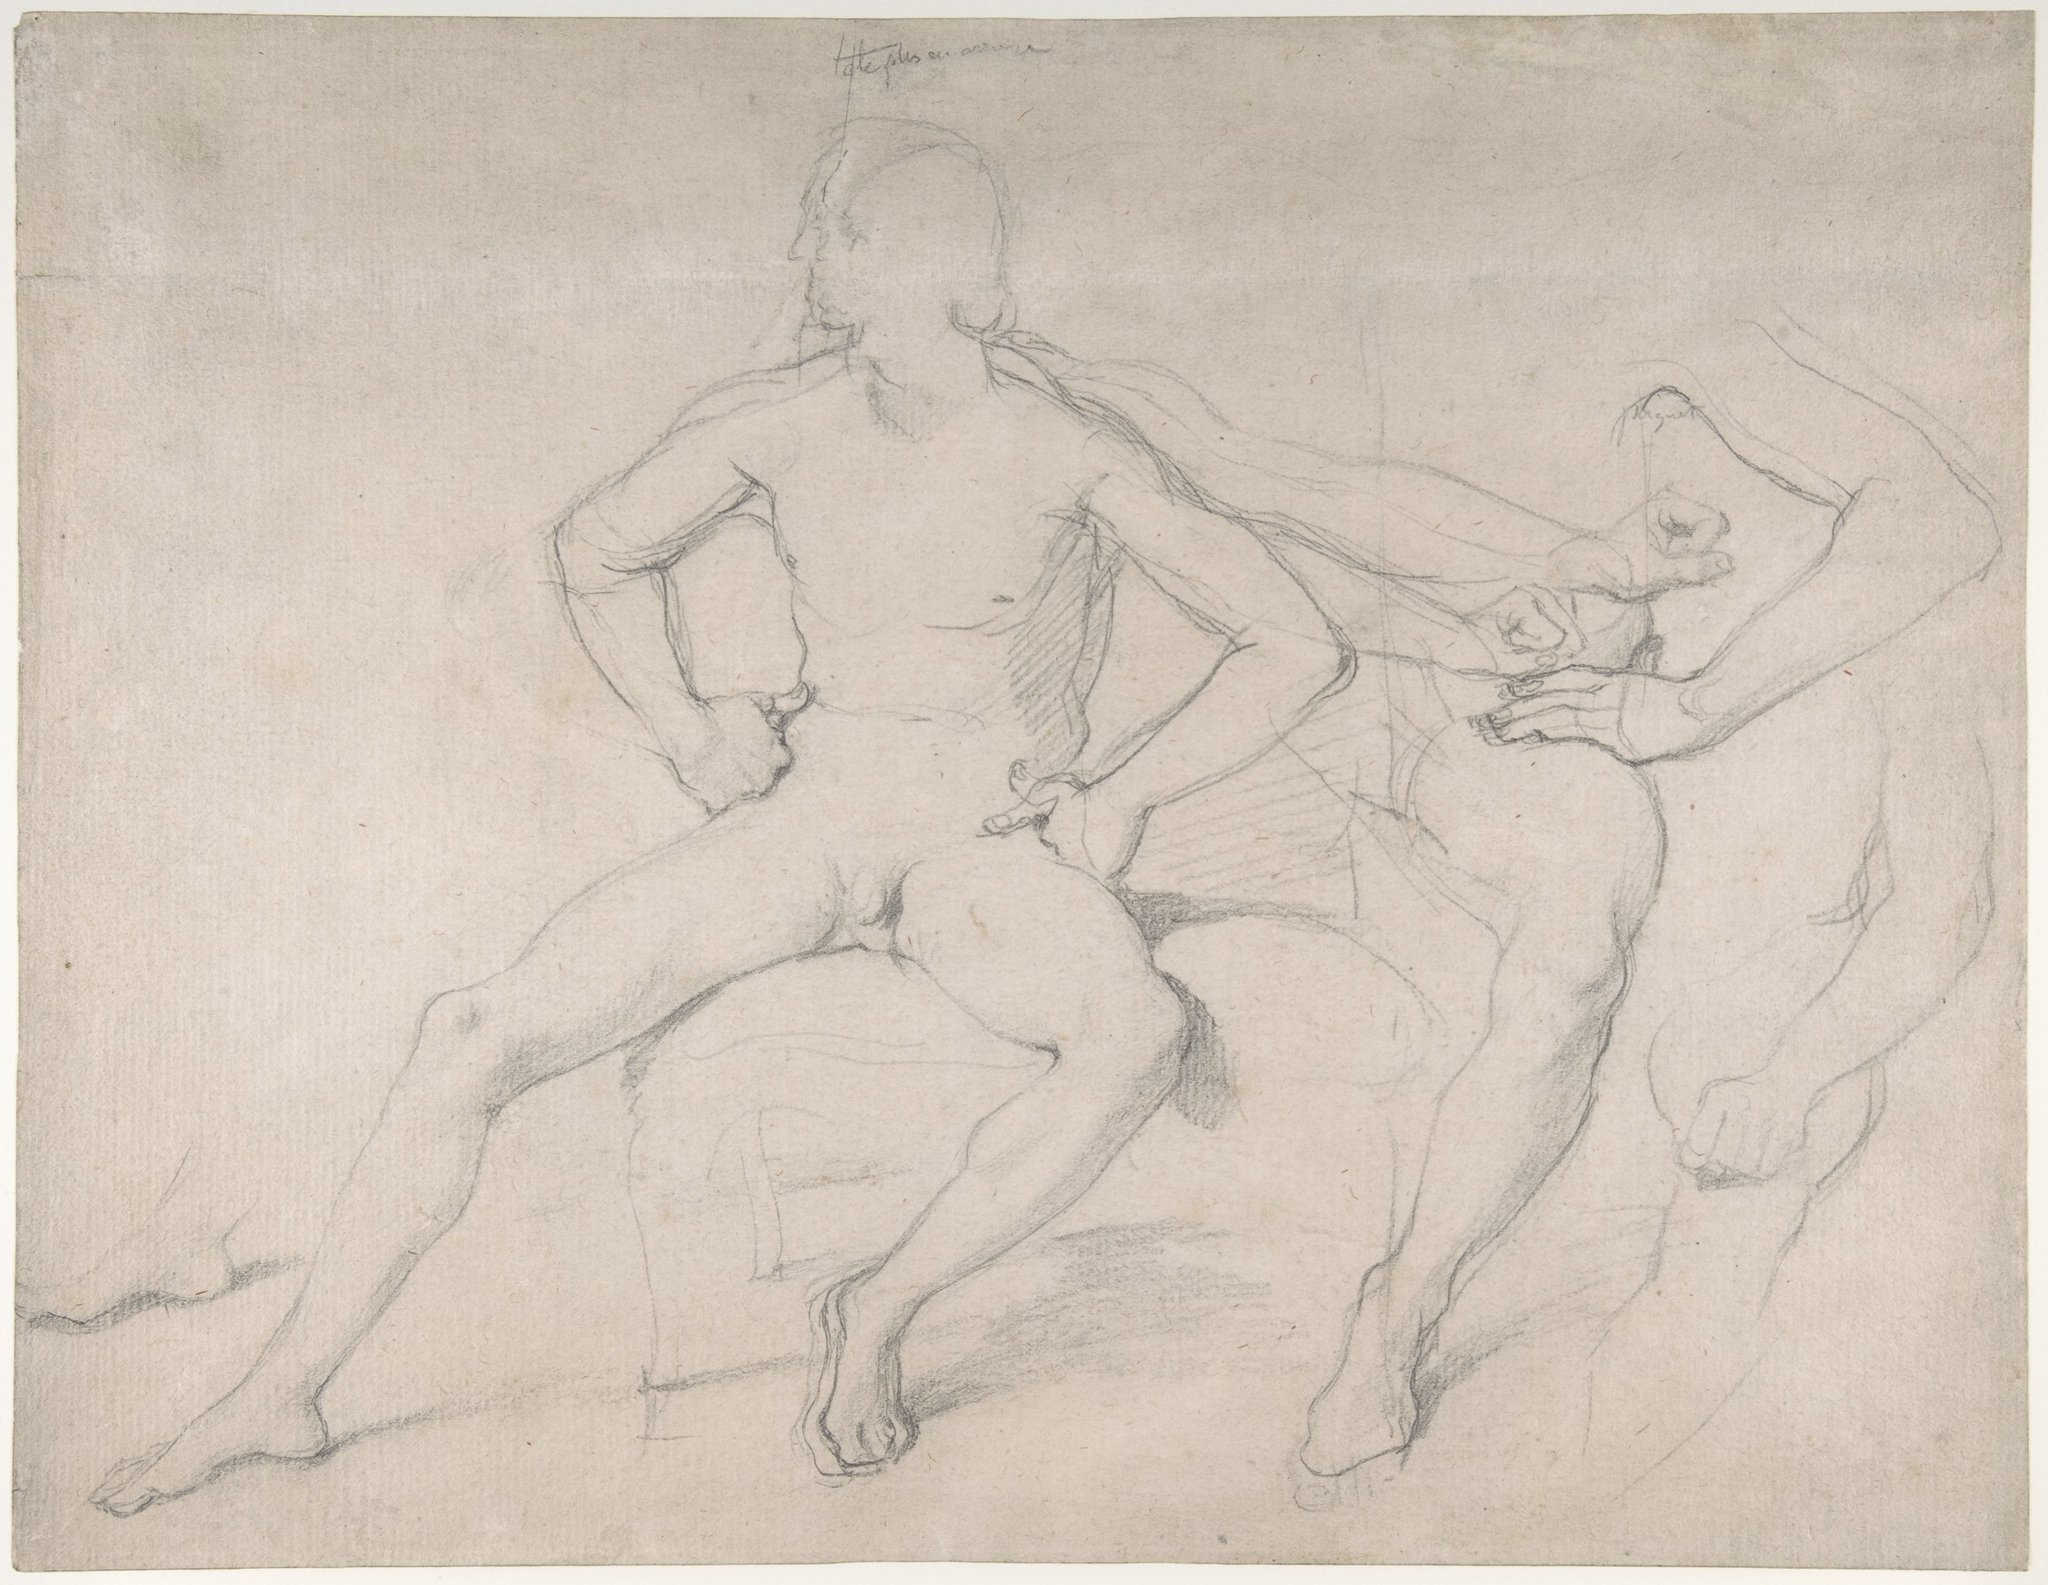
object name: drawing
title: Study of a Seated Nude Male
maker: jean auguste dominique ingres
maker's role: artist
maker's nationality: french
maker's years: 1780-1867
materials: graphite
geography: france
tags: male nudes